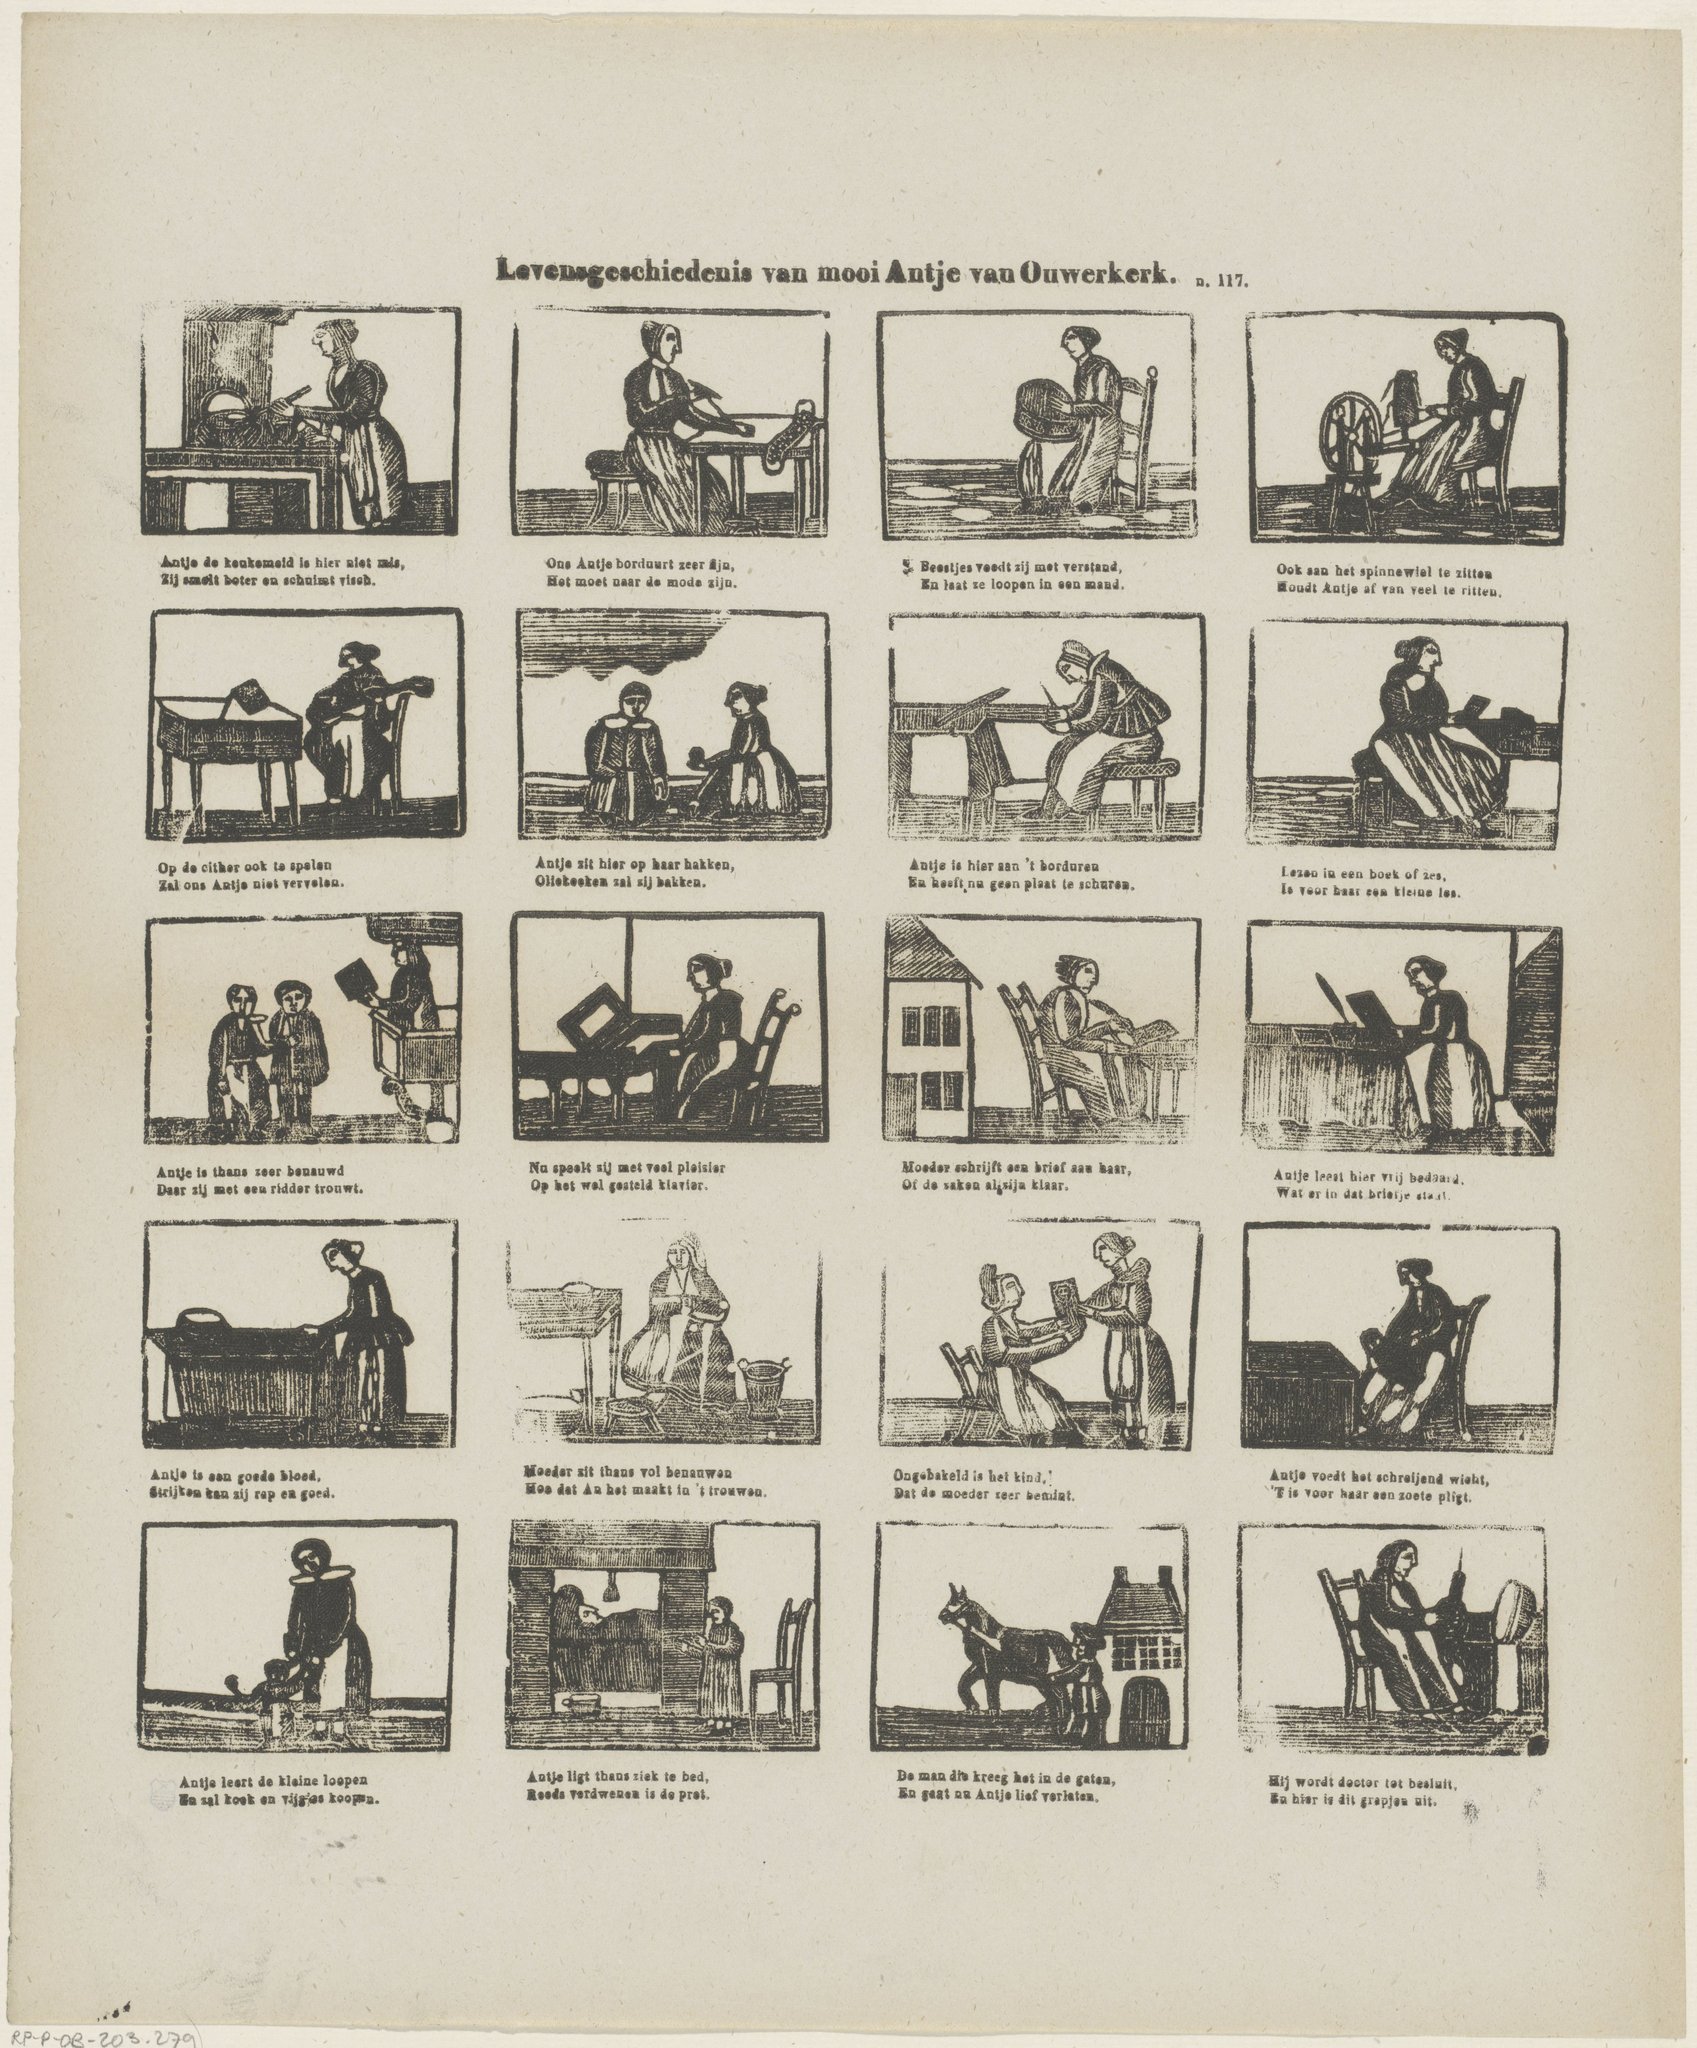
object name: popular print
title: Levensgeschiedenis van mooi Antje van Ouwerkerk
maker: Anonymous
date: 1833-1900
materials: paper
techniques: letterpress printing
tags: tales and fairy tales, kitchen-maid, kitchen servant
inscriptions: collector's mark: Lugt 2760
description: Blad met 20 voorstellingen over het leven van de keukenmeid Antje van Ouwerkerk. Onder elke afbeelding een tweeregelig vers. Genummerd rechtsboven: n. 117.